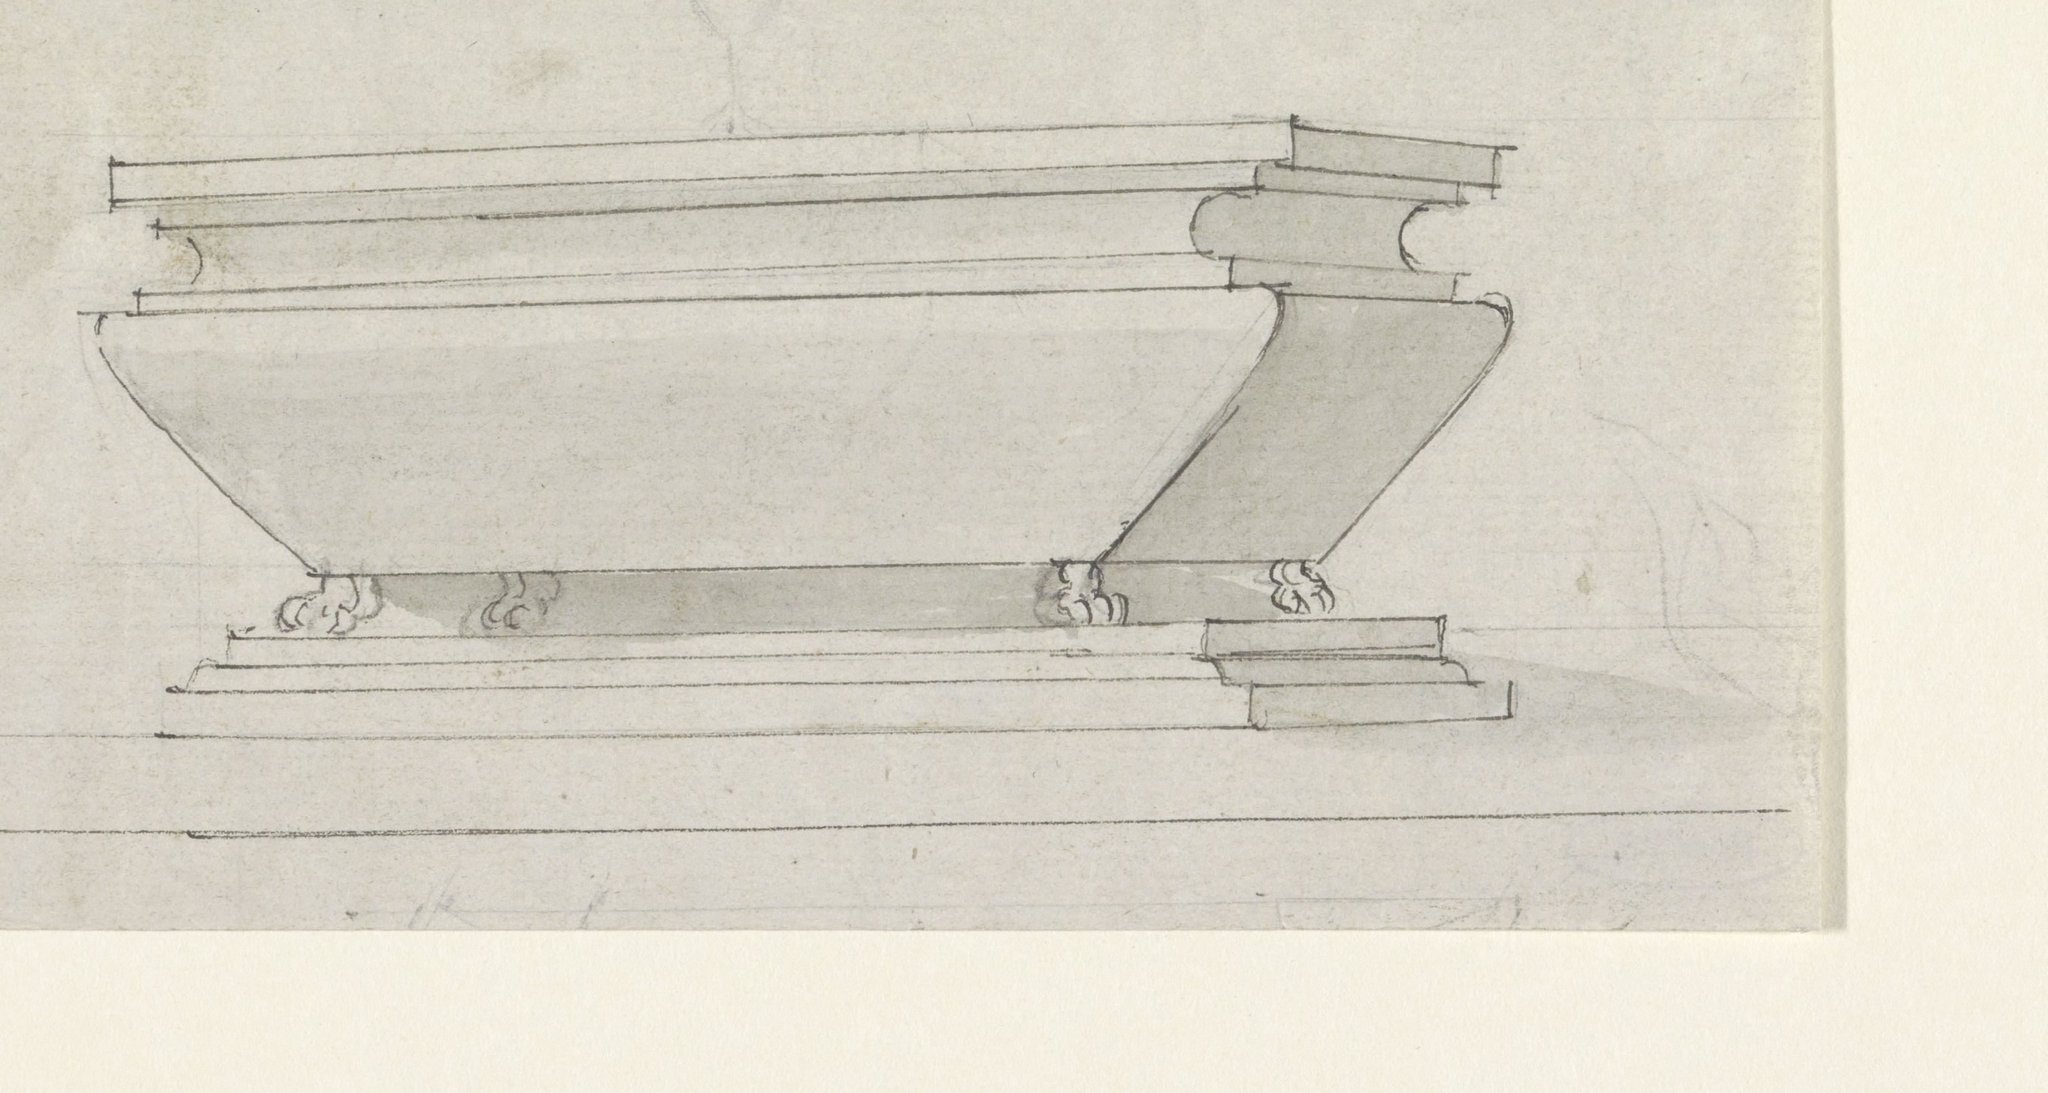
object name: ornamenttekening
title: Graftombe op leeuwenpoten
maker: Anonymous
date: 1650-1800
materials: ink, paper, pencil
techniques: brush, pen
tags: grave, tomb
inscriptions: collector's mark: Lugt 2228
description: Een graftombe met leeuwenpoten op een plint.